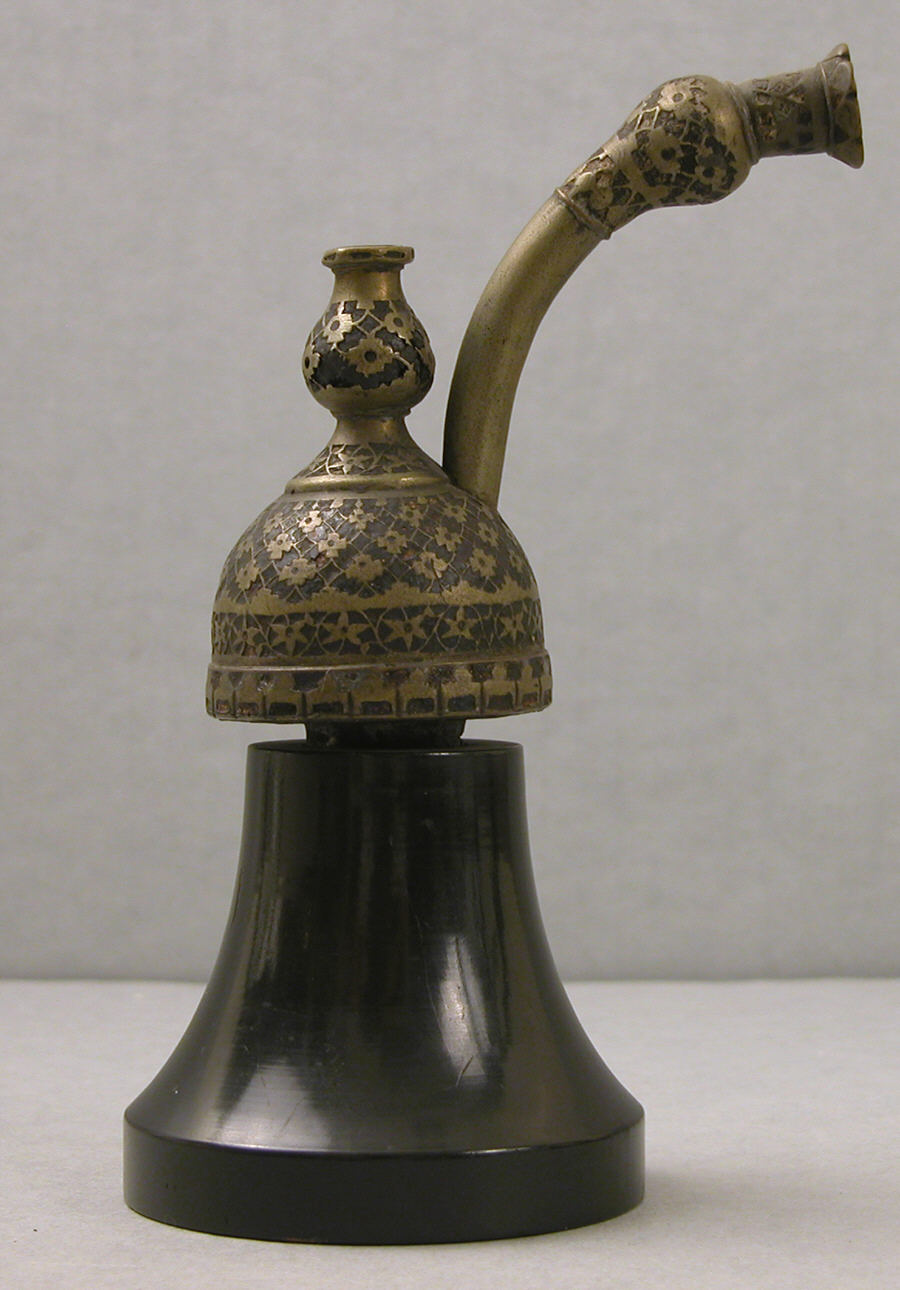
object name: water pipe top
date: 1801-1900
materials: alloy, brass, zinc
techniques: casting, engraving, inlay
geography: india